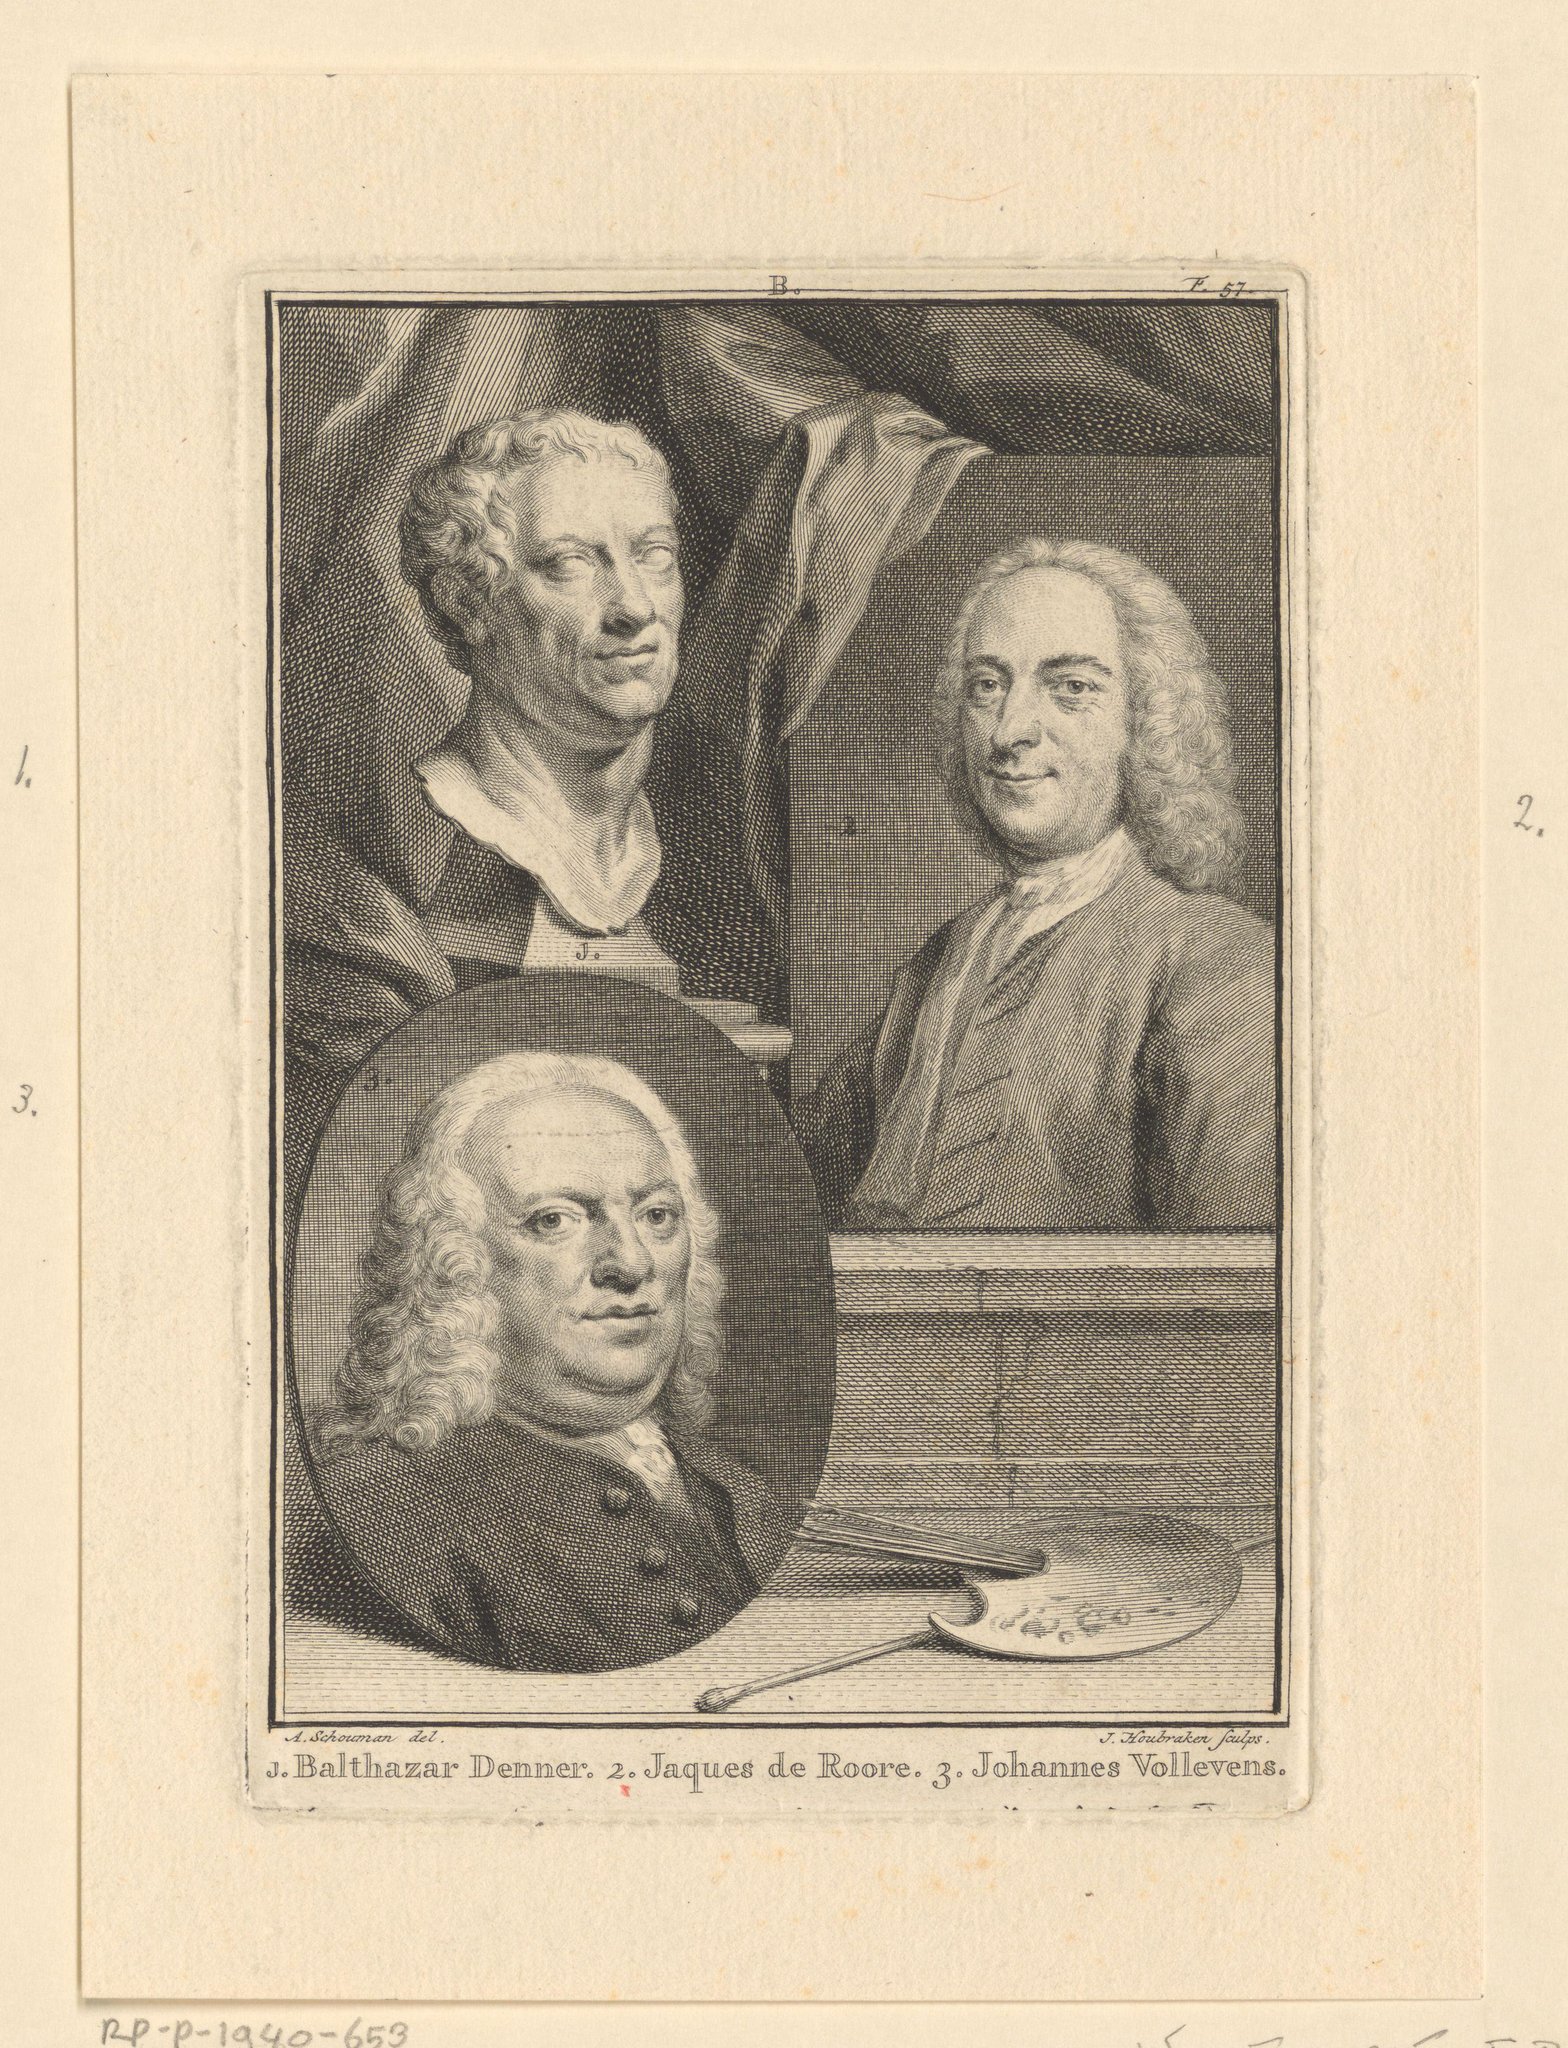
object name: print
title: Portretten van Balthasar Denner, Jacques Ignatius de Rooze en Johannes Vollevens II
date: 1750-1751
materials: paper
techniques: engraving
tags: balthasar denner, antwerp, jacques ignatius de roore, the hague, johannes vollevens (ii), chest, bust, historical persons, portrait, self-portrait of painter, tools, implements of painter, brushes ~ implements of painter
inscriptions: inscription: ‘JvGool’, collector's mark: Lugt 2760, collector's mark: Lugt 2228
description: Prent waarschijnlijk uit: Gool, Johan van. De nieuwe schouburg der Nederlantsche kunstschilders en schilderessen (...). 2 dln. Den Haag: Johan van Gooi, 1750-1751.